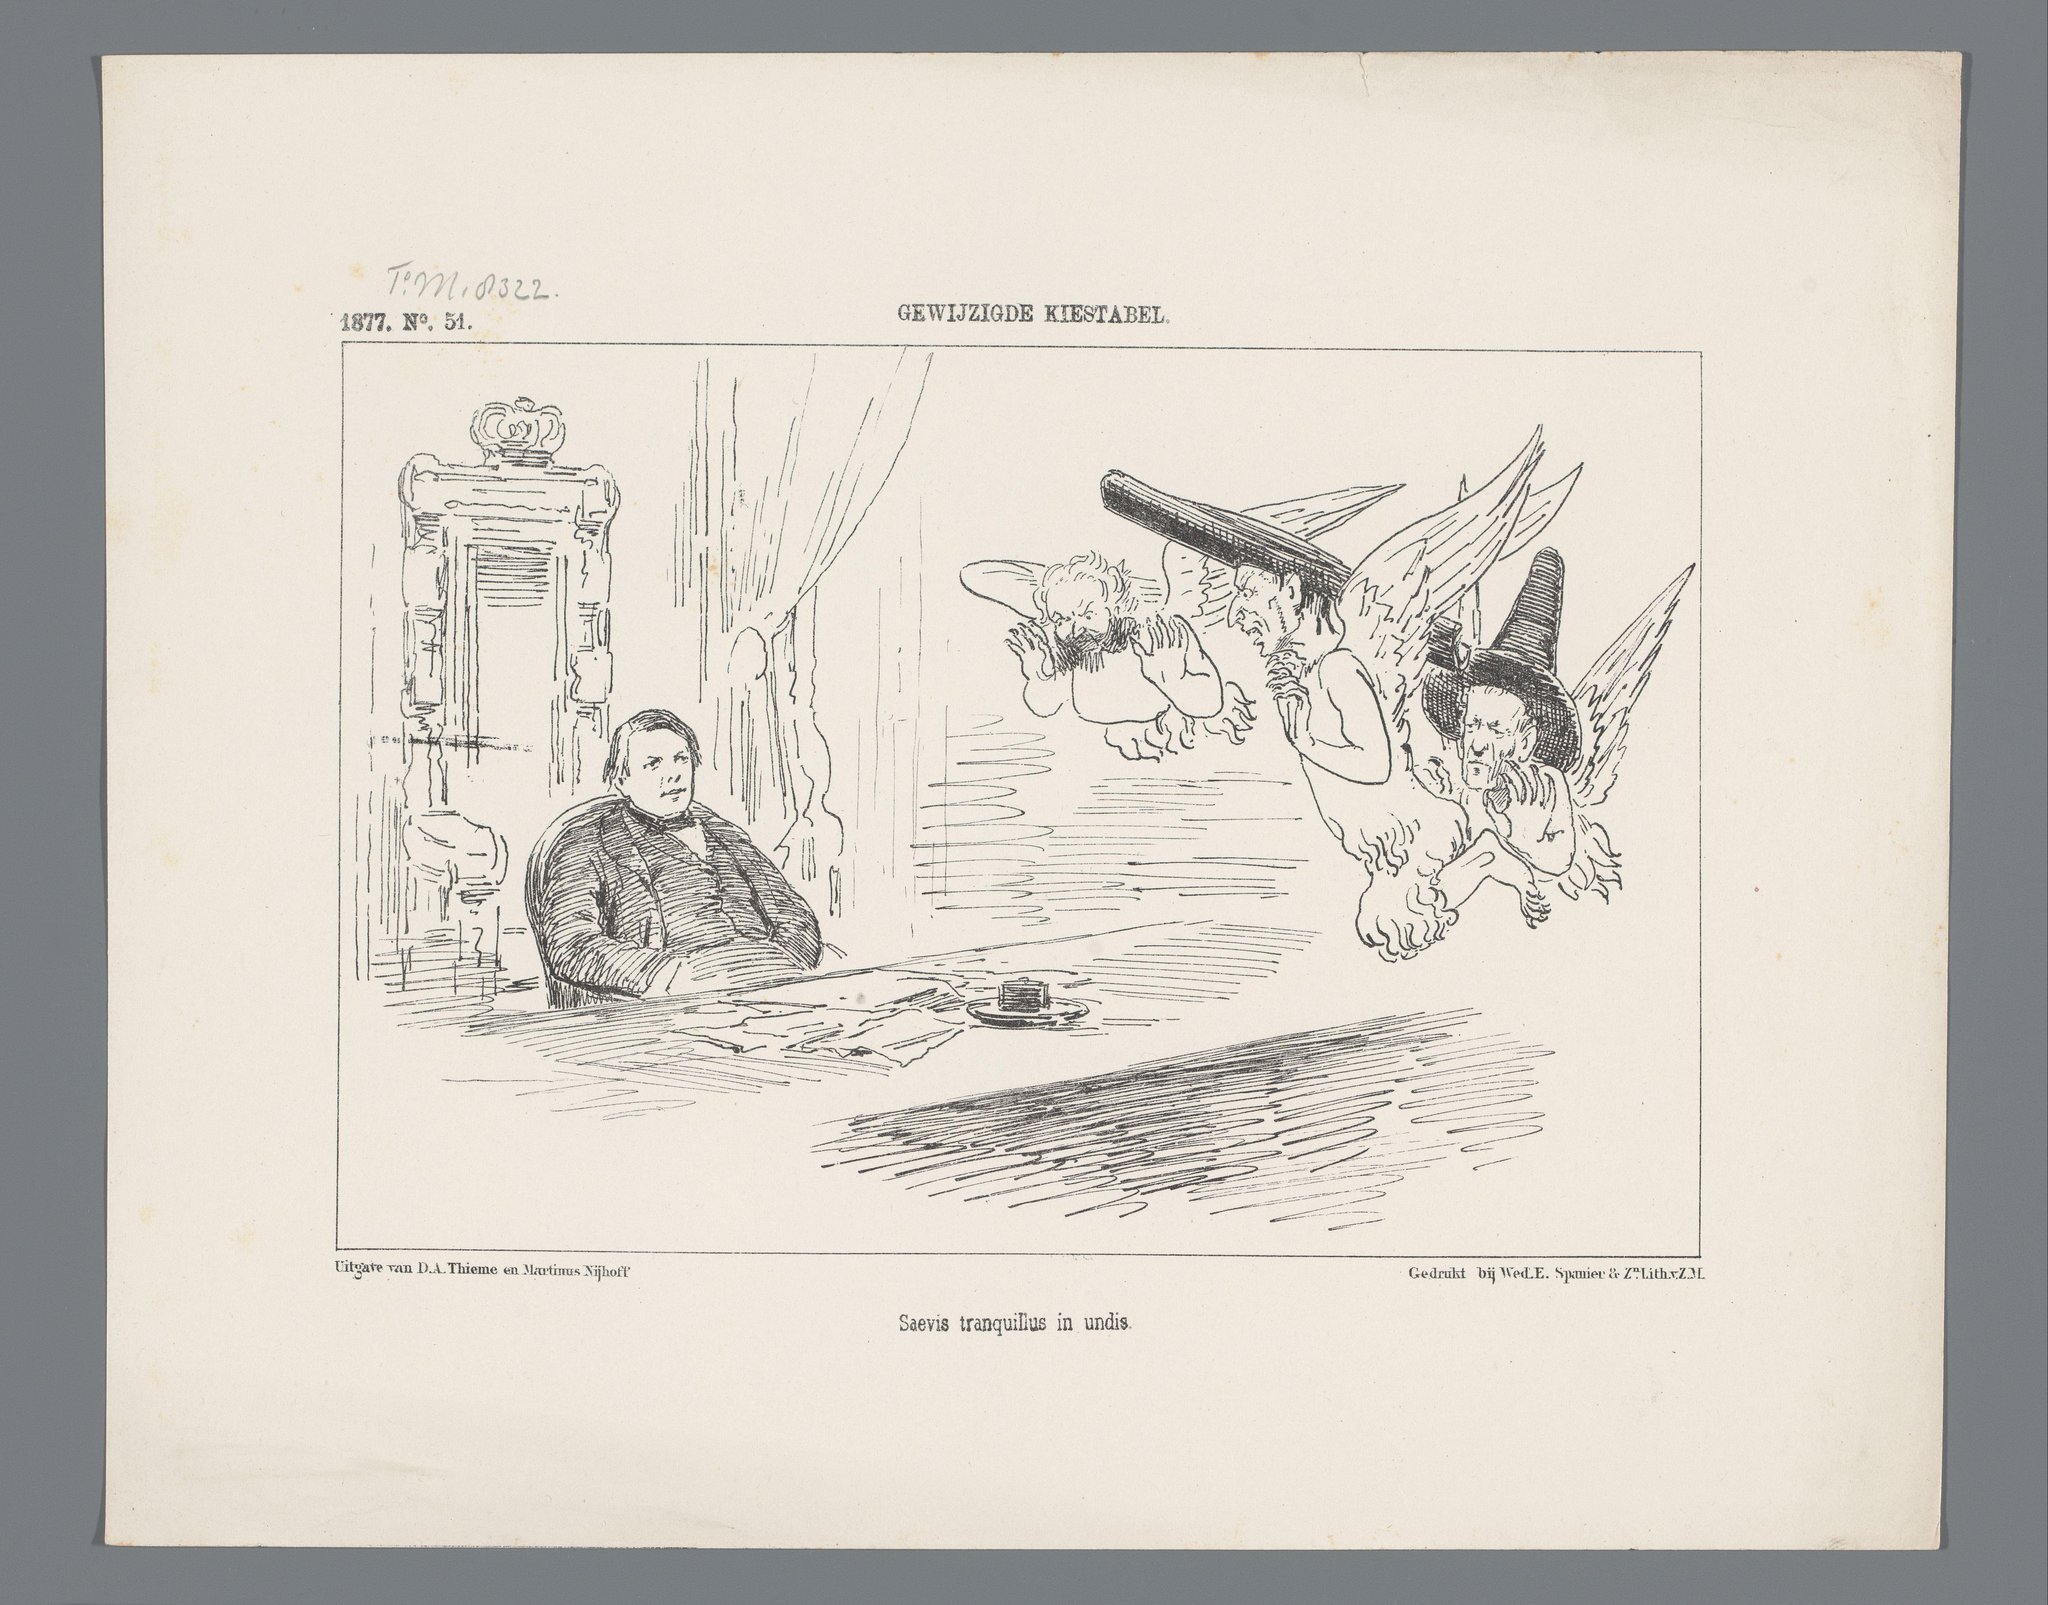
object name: print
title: Gewijzigde kiestabel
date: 1877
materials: paper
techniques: lithograph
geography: netherlands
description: Spotprent. Plaat verschenen bij het weekblad De Nederlandsche Spectator, nr. 51, 1877.